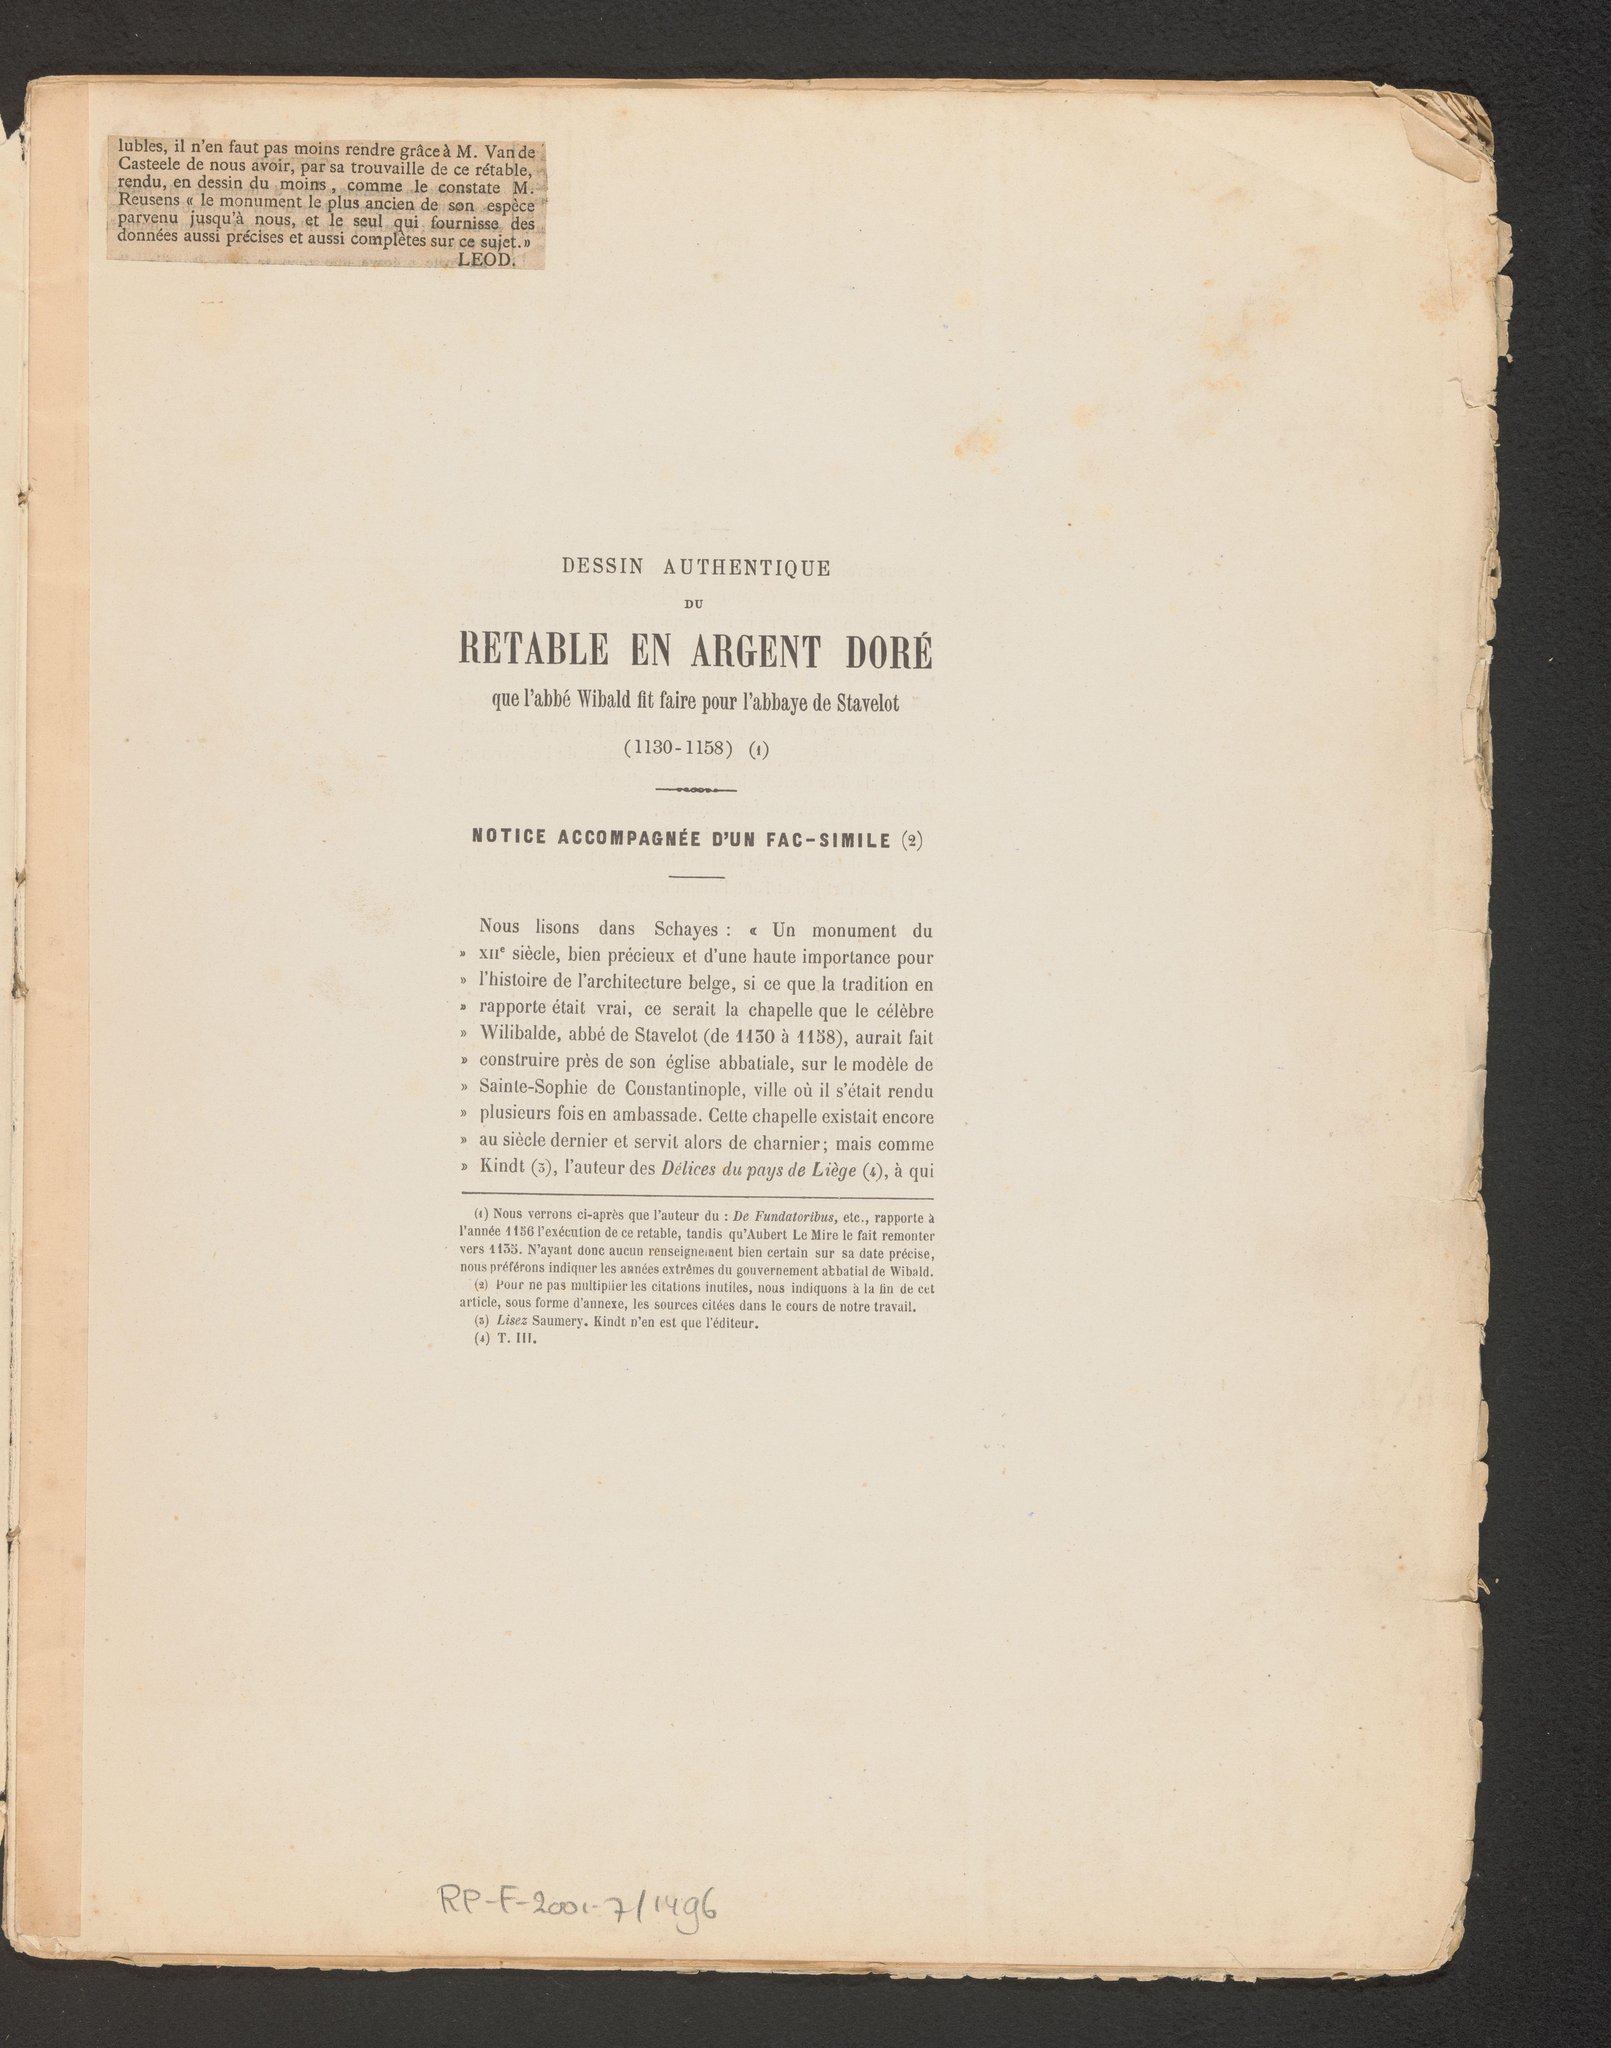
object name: book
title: Dessin authentique du retable en argent doré que l'abbé Wibald fit faire pour l'abbaye de Stavelot (1130-1158) / notice acc. d'un fac-simile par Désiré van de Casteele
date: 1882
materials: paper, photographic support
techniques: albumen print, lithograph, printing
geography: brussels